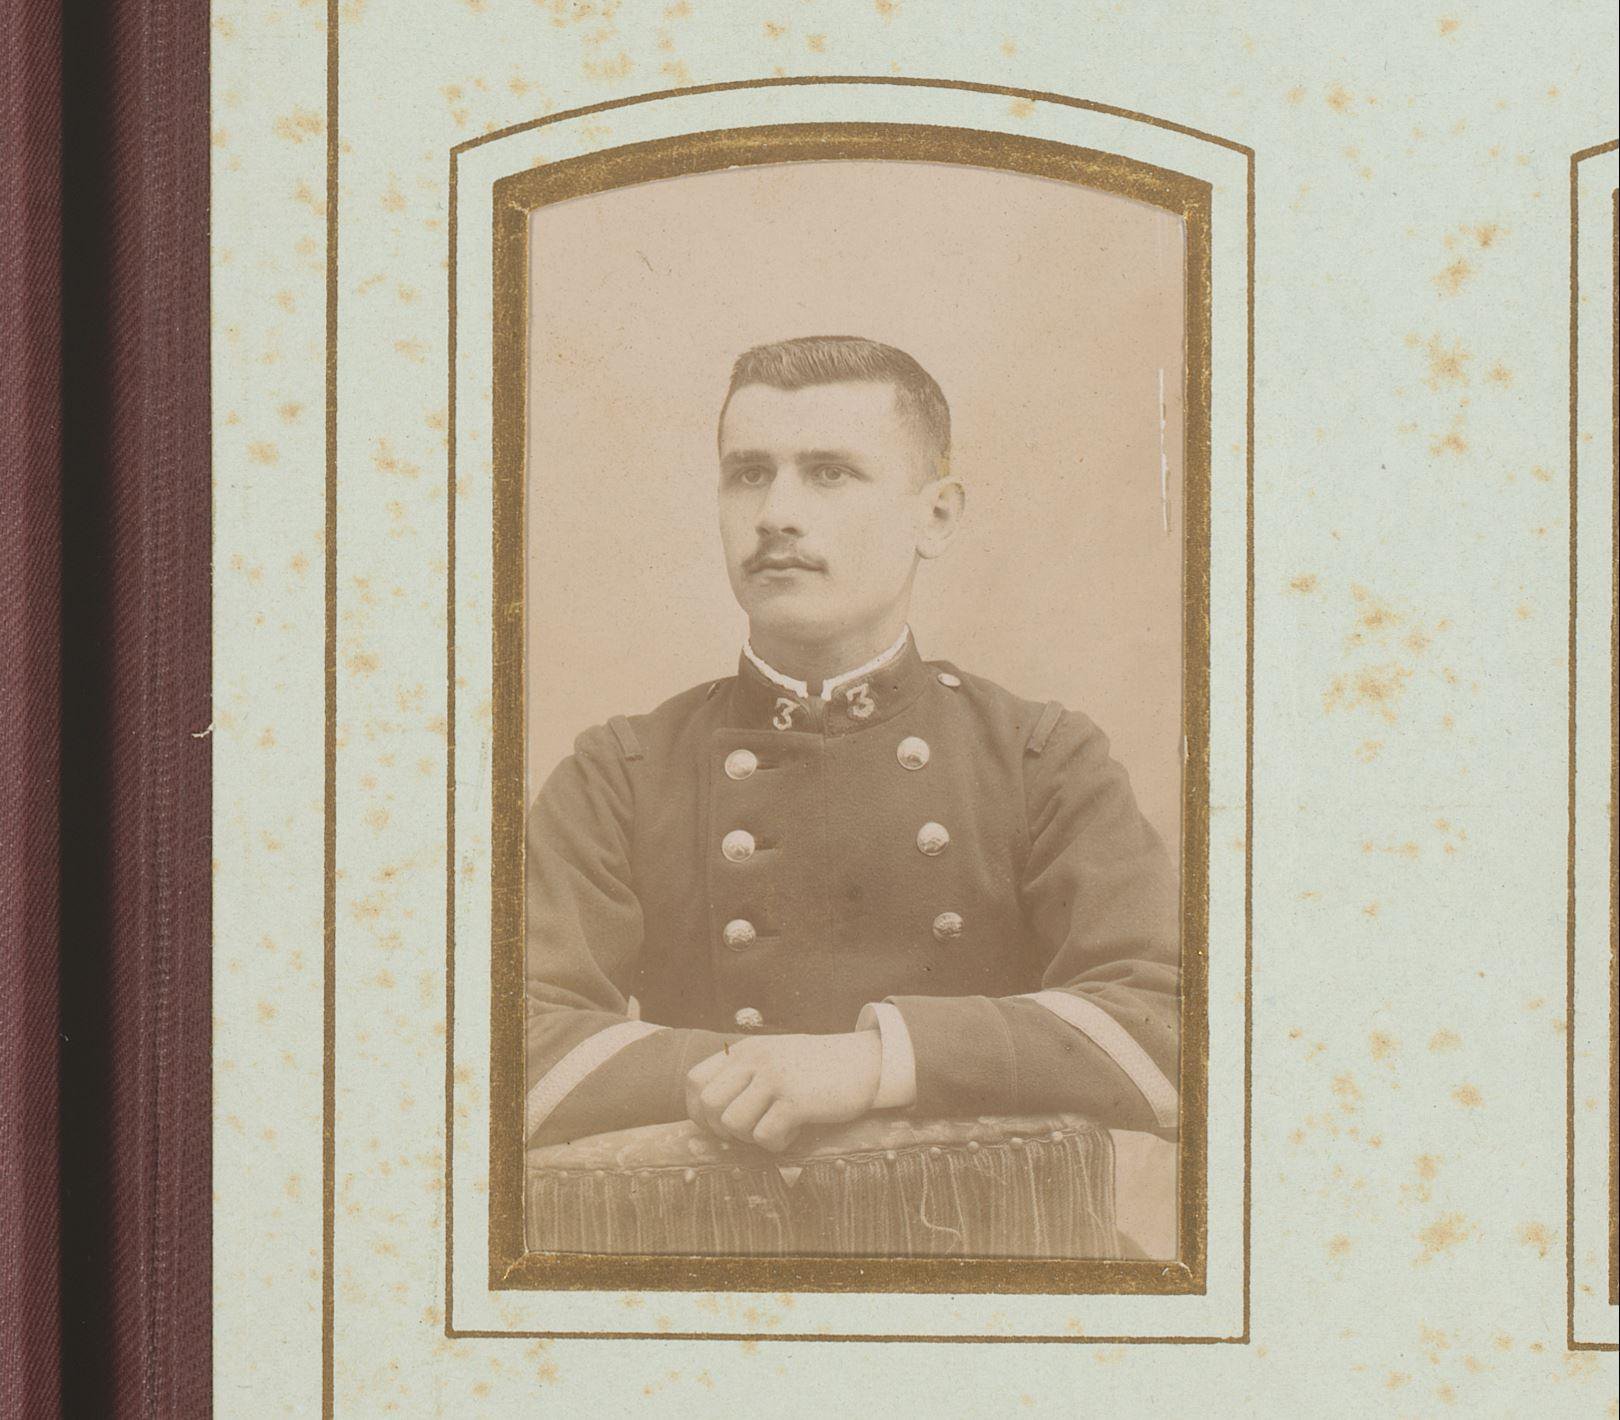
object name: album leaf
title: Portret van een man in uniform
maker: Anonymous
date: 1880-1920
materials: cardboard, photographic support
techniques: daylight paper print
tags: historical persons